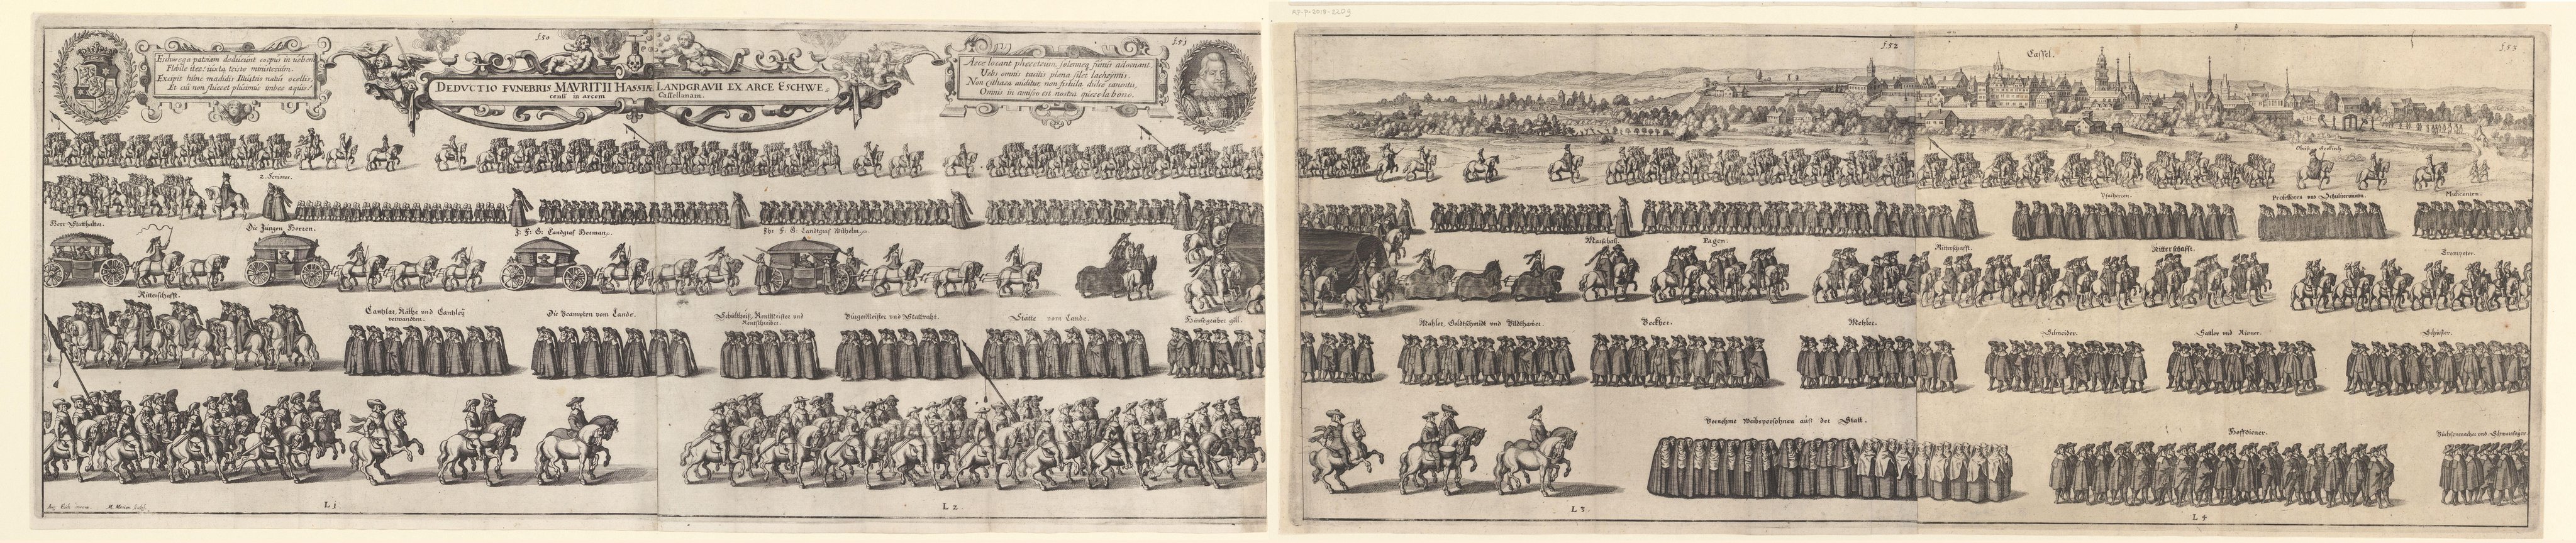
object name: print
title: Het Stadhouderlijk Kwartier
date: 1879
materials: paper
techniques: lithograph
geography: the hague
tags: national government